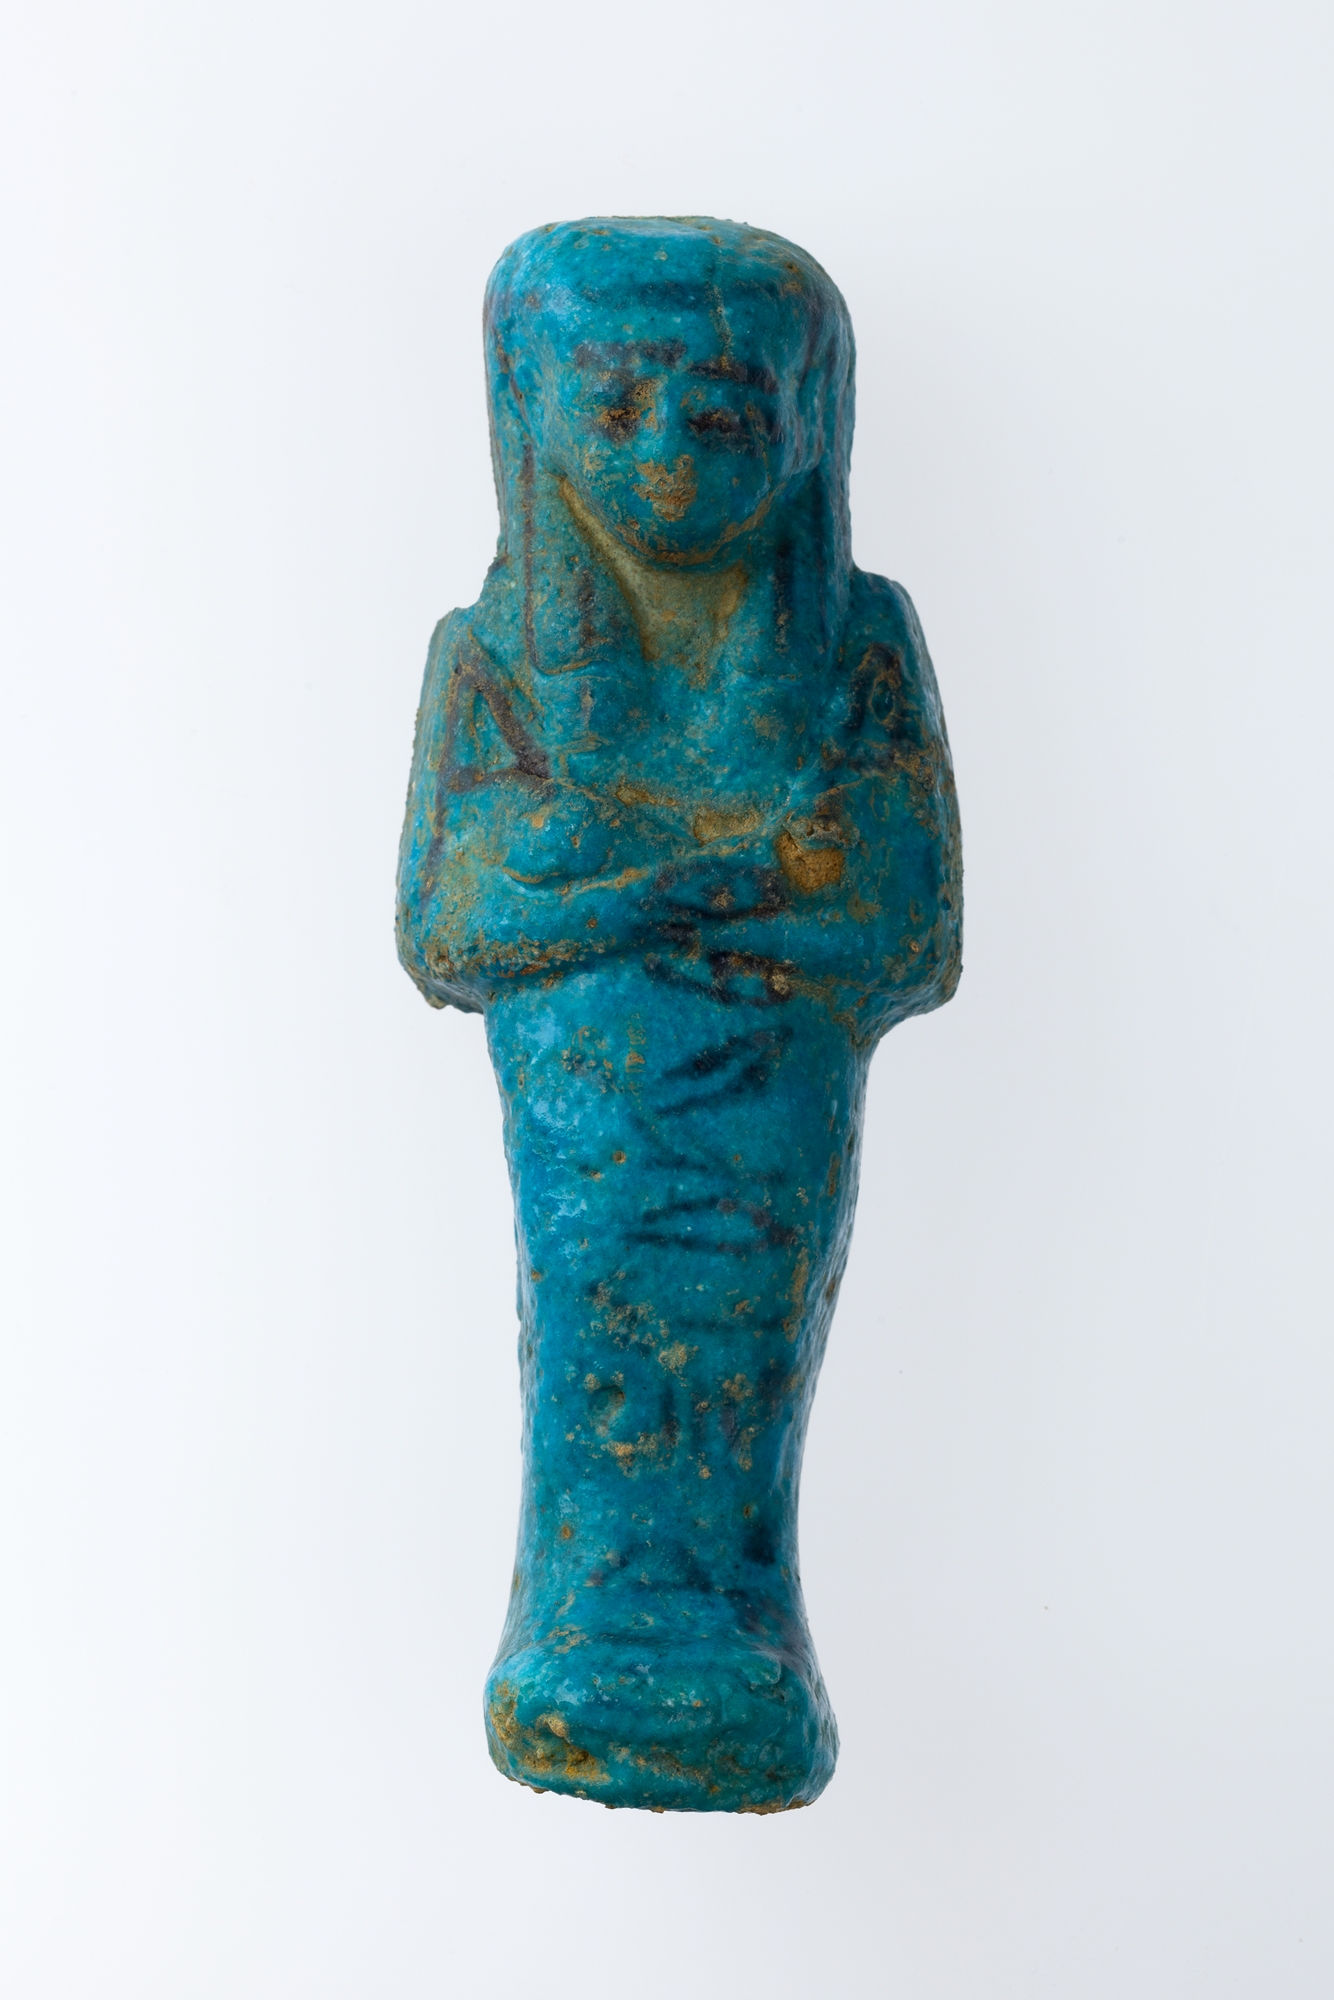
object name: shabti, henettawy c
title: Worker Shabti of Henettawy (C), Daughter of Isetemkheb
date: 990-970 BCE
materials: faience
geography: egypt